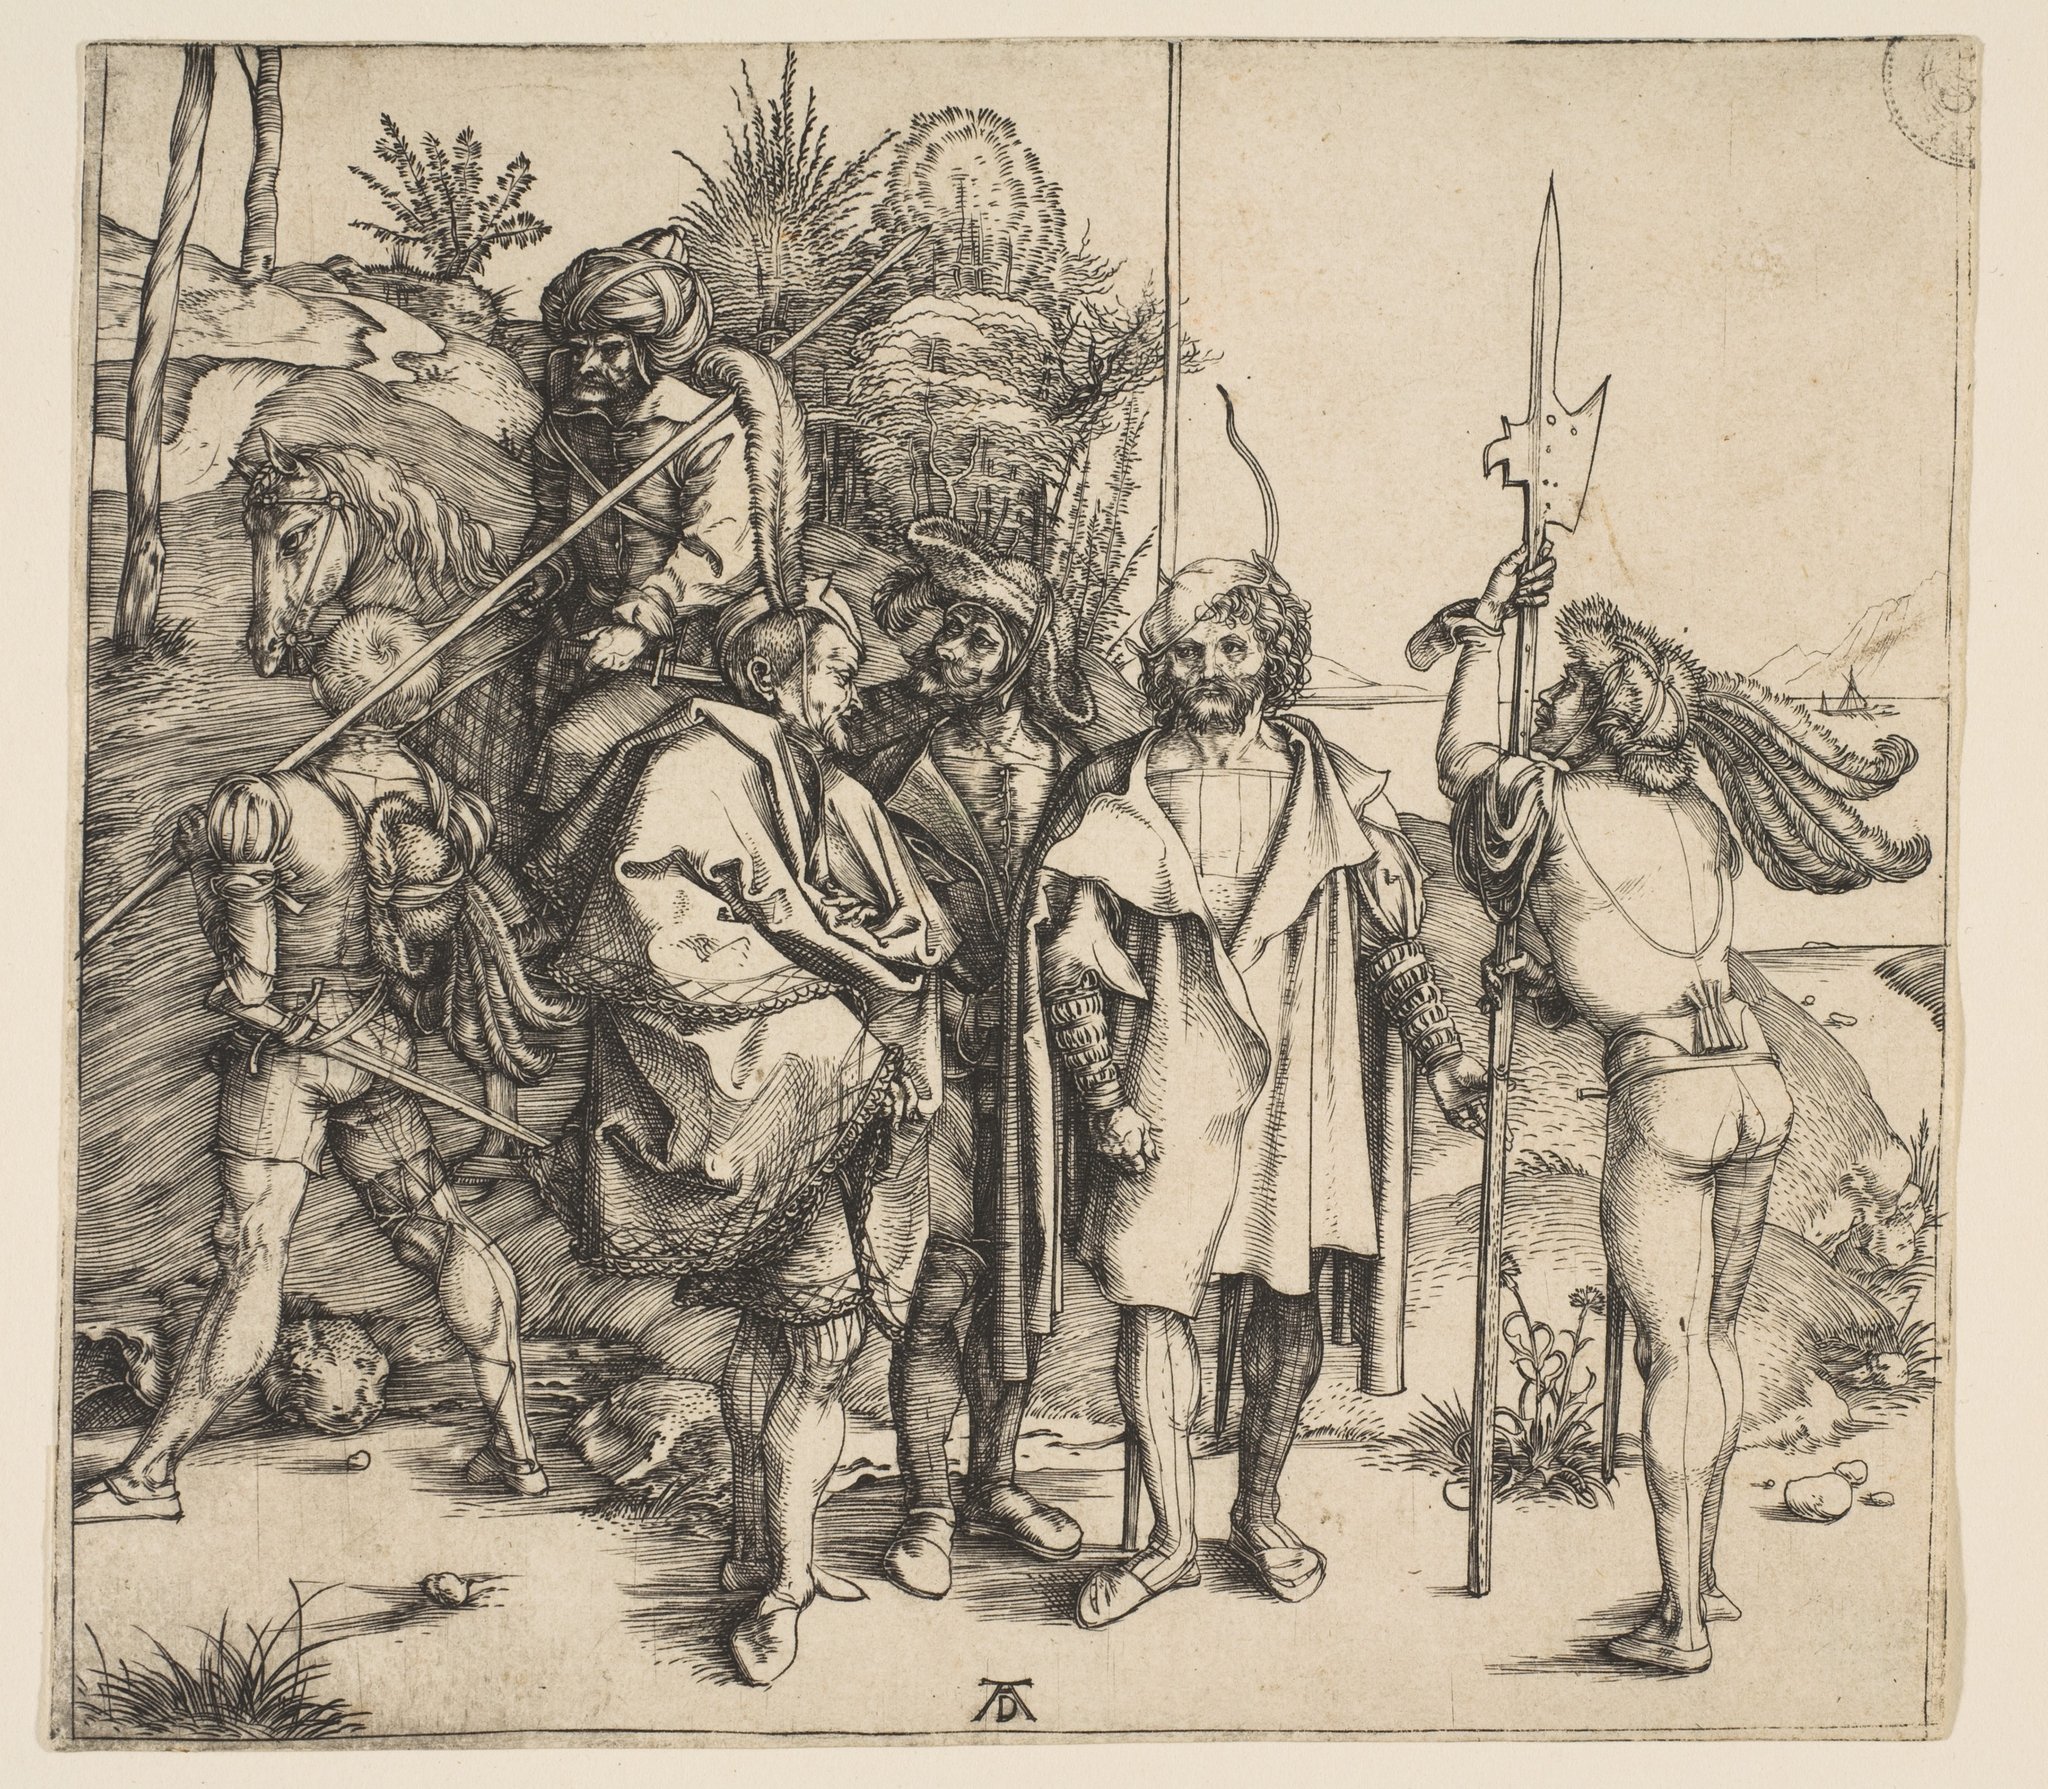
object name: print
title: Five Foot Soldiers and a Mounted Turk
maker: albrecht dürer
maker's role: artist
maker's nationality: german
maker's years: 1471-1528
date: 1495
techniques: engraving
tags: soldiers,weapons,men,horses